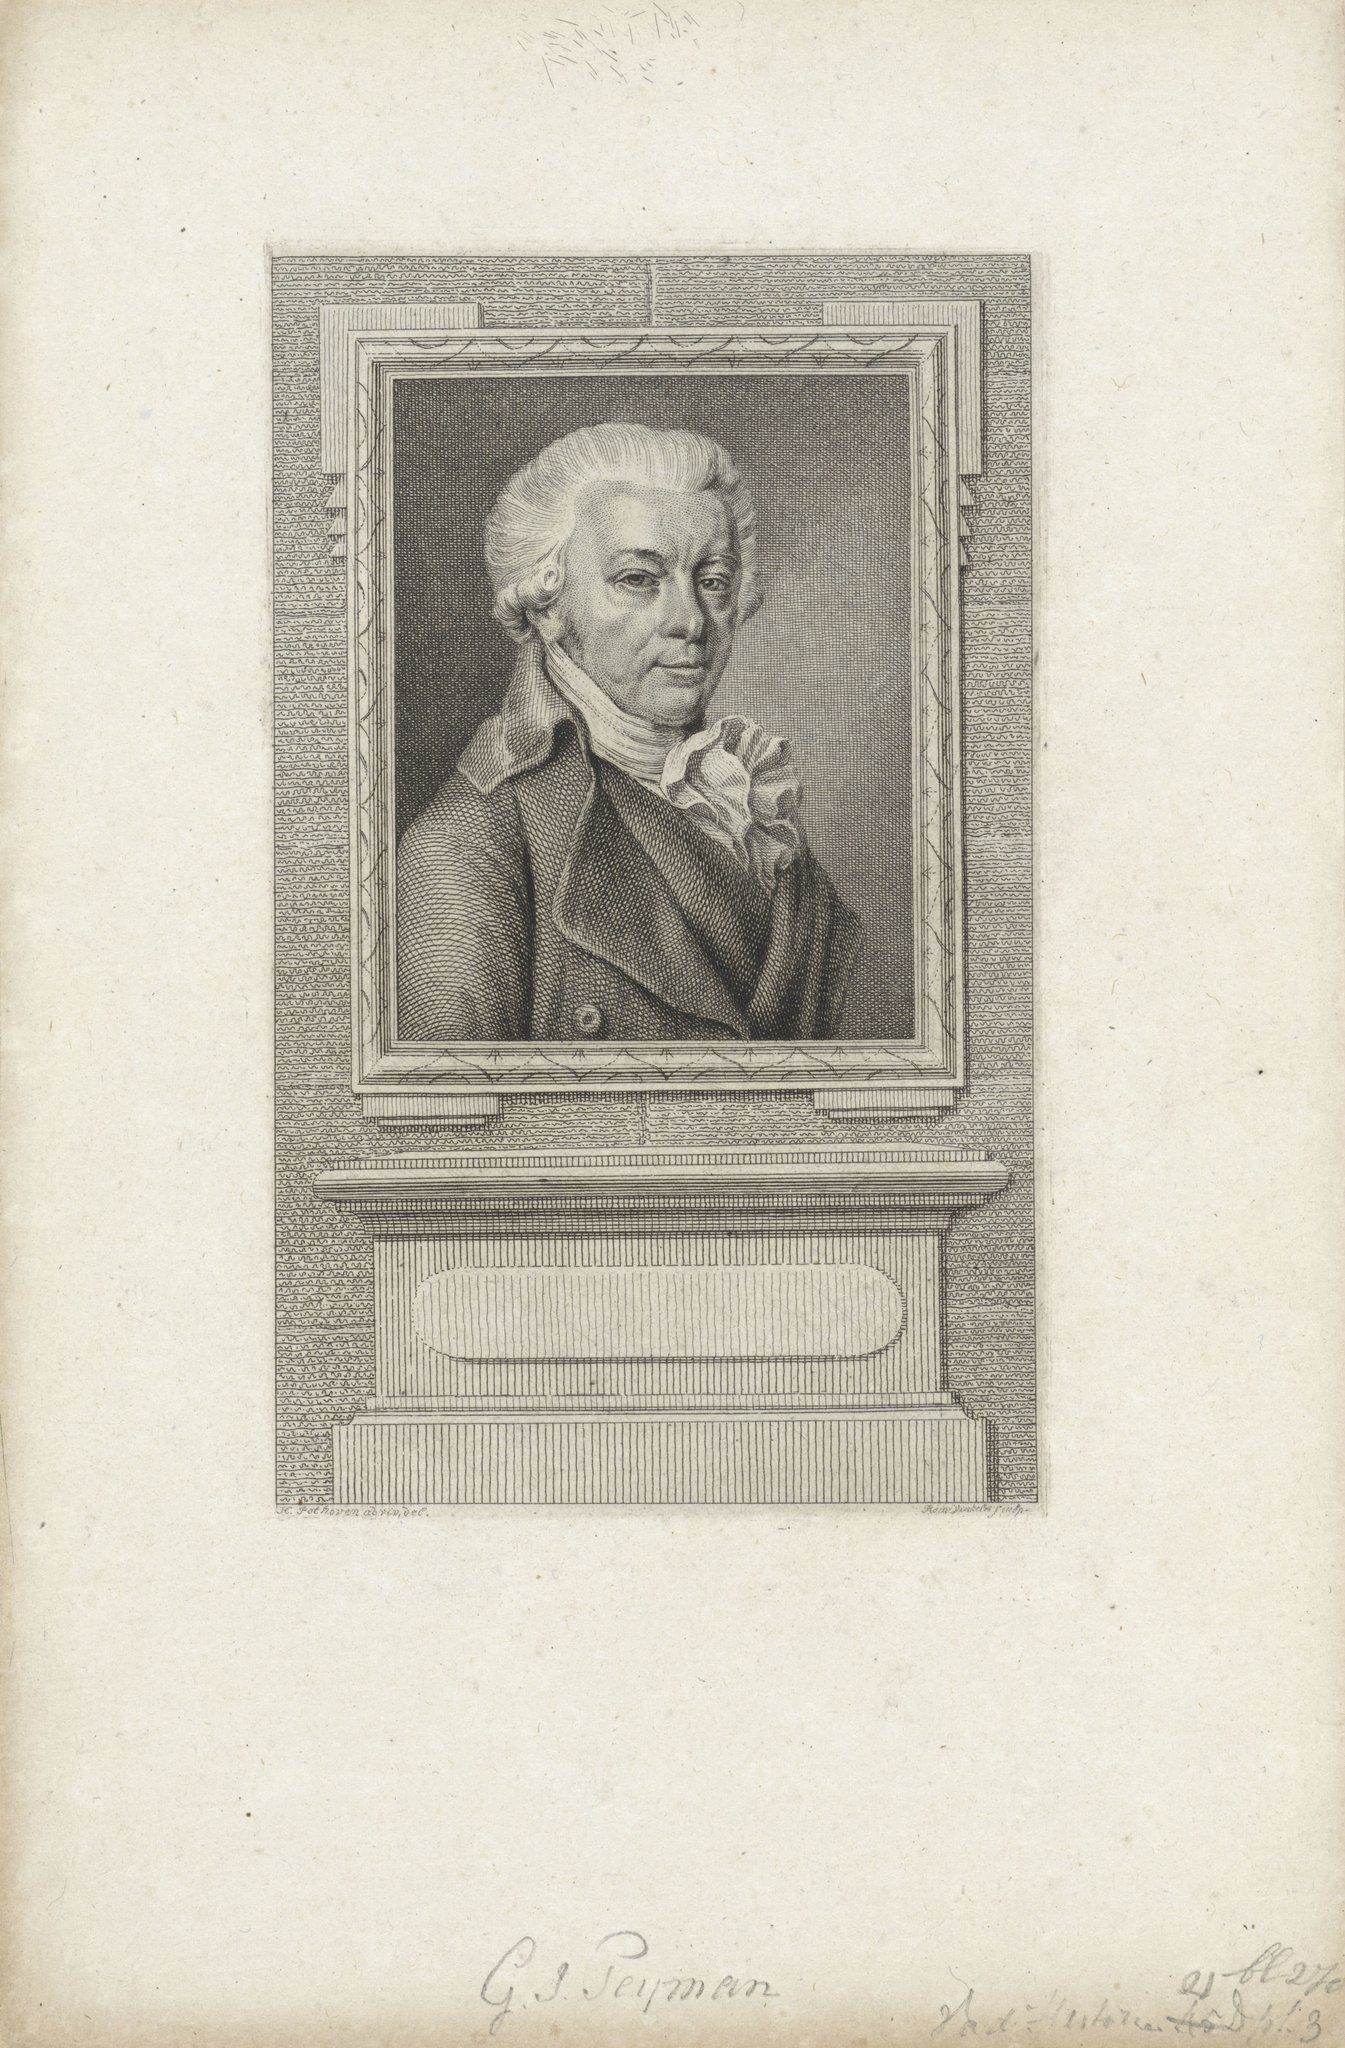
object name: print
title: Portret van Gerrit Jan Pijman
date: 1789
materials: paper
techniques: engraving, etching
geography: amsterdam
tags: utrecht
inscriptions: collector's mark: Lugt 2228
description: Latere staat prent gebruikt als boekillustratie in: Wagenaar, Jan. Vaderlandsche historie, (...) ten vervolge van Wagenaars Vaderlandsche historie. Dl. 1-43. Amsterdam: Johannes Allart, 1786-1809.